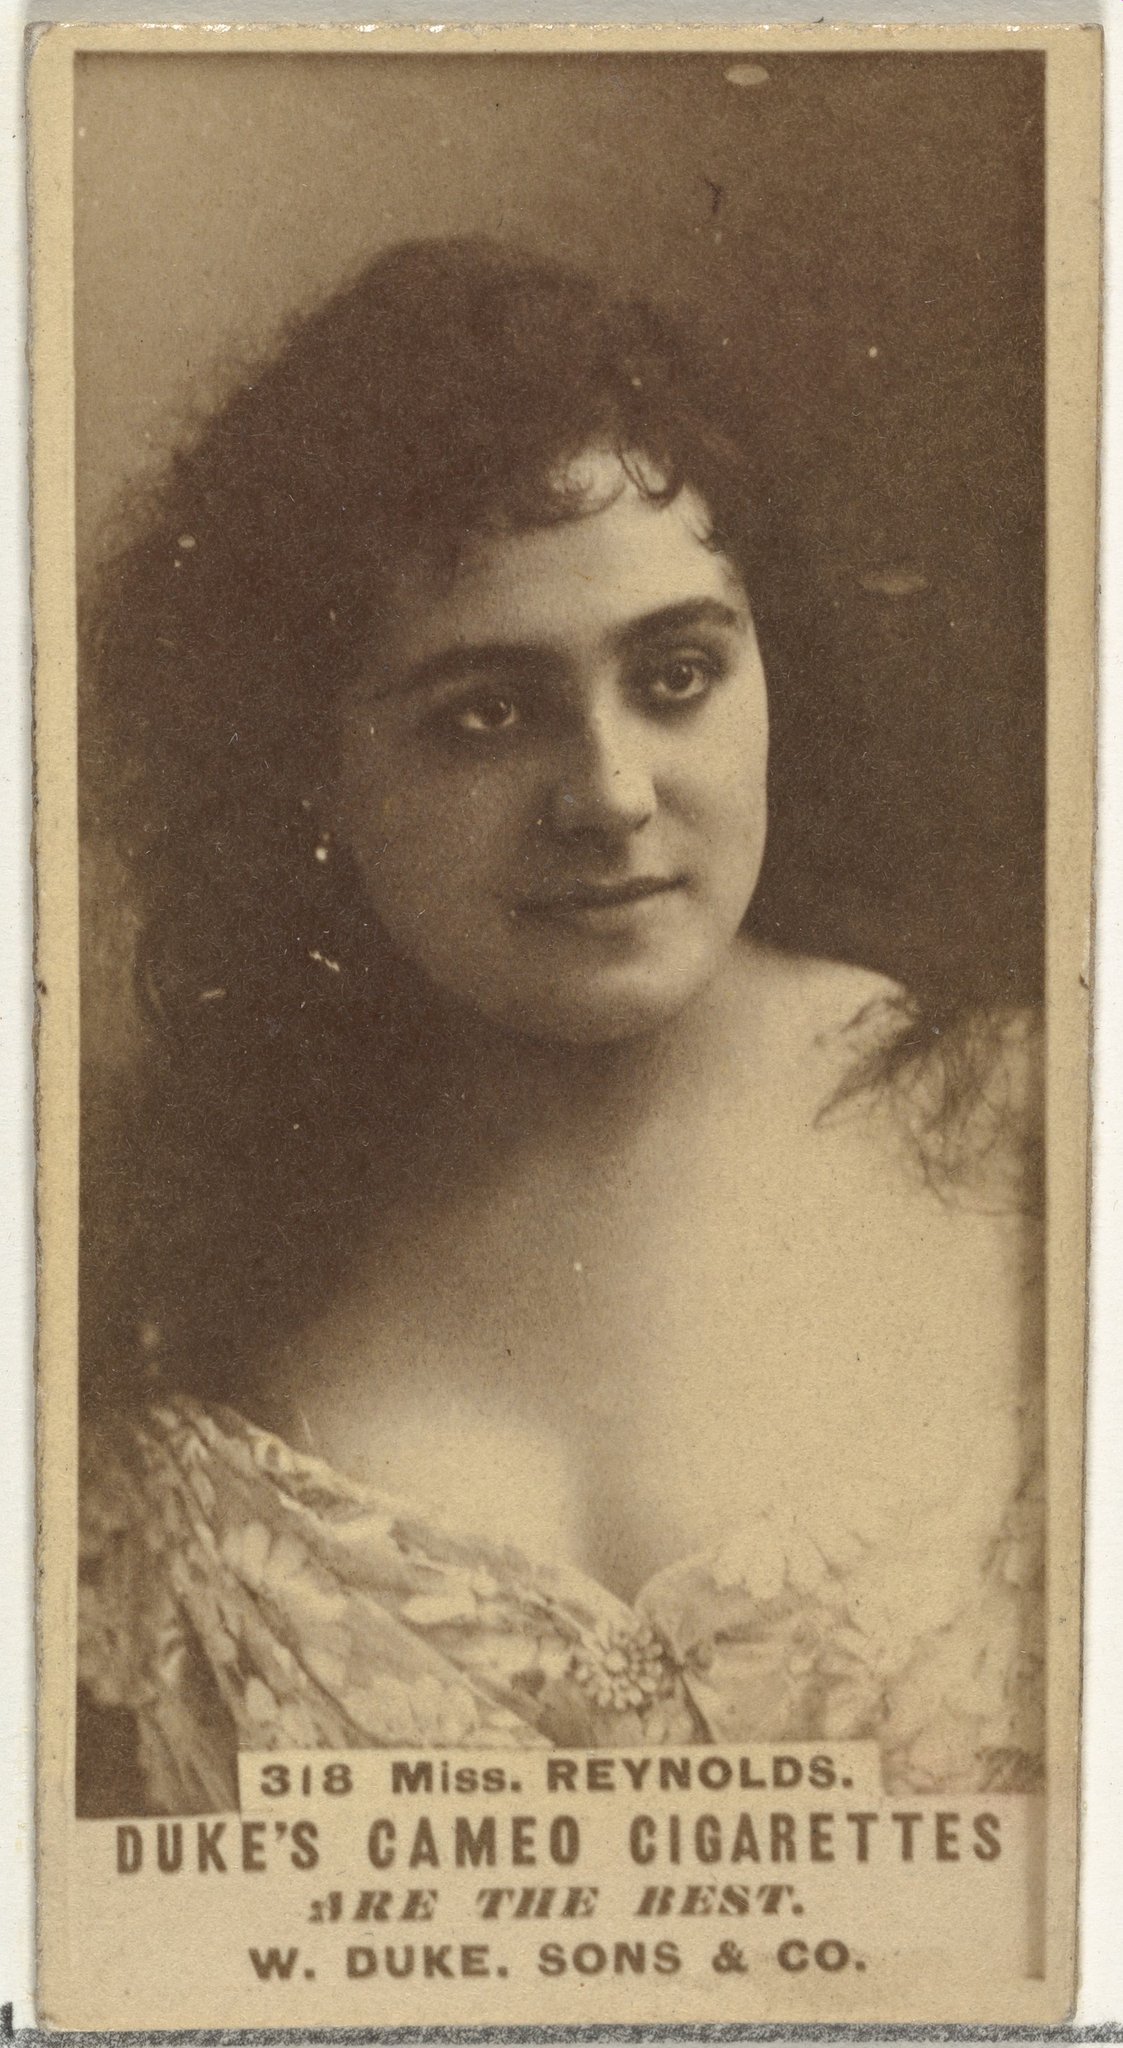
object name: photograph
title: Card Number 318, Miss Reynolds, from the Actors and Actresses series (N145-5) issued by Duke Sons & Co. to promote Cameo Cigarettes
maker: w. duke, sons & co.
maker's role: publisher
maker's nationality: american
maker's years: 1870-1920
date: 1880-1889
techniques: albumen silver print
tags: portraits,women,actresses